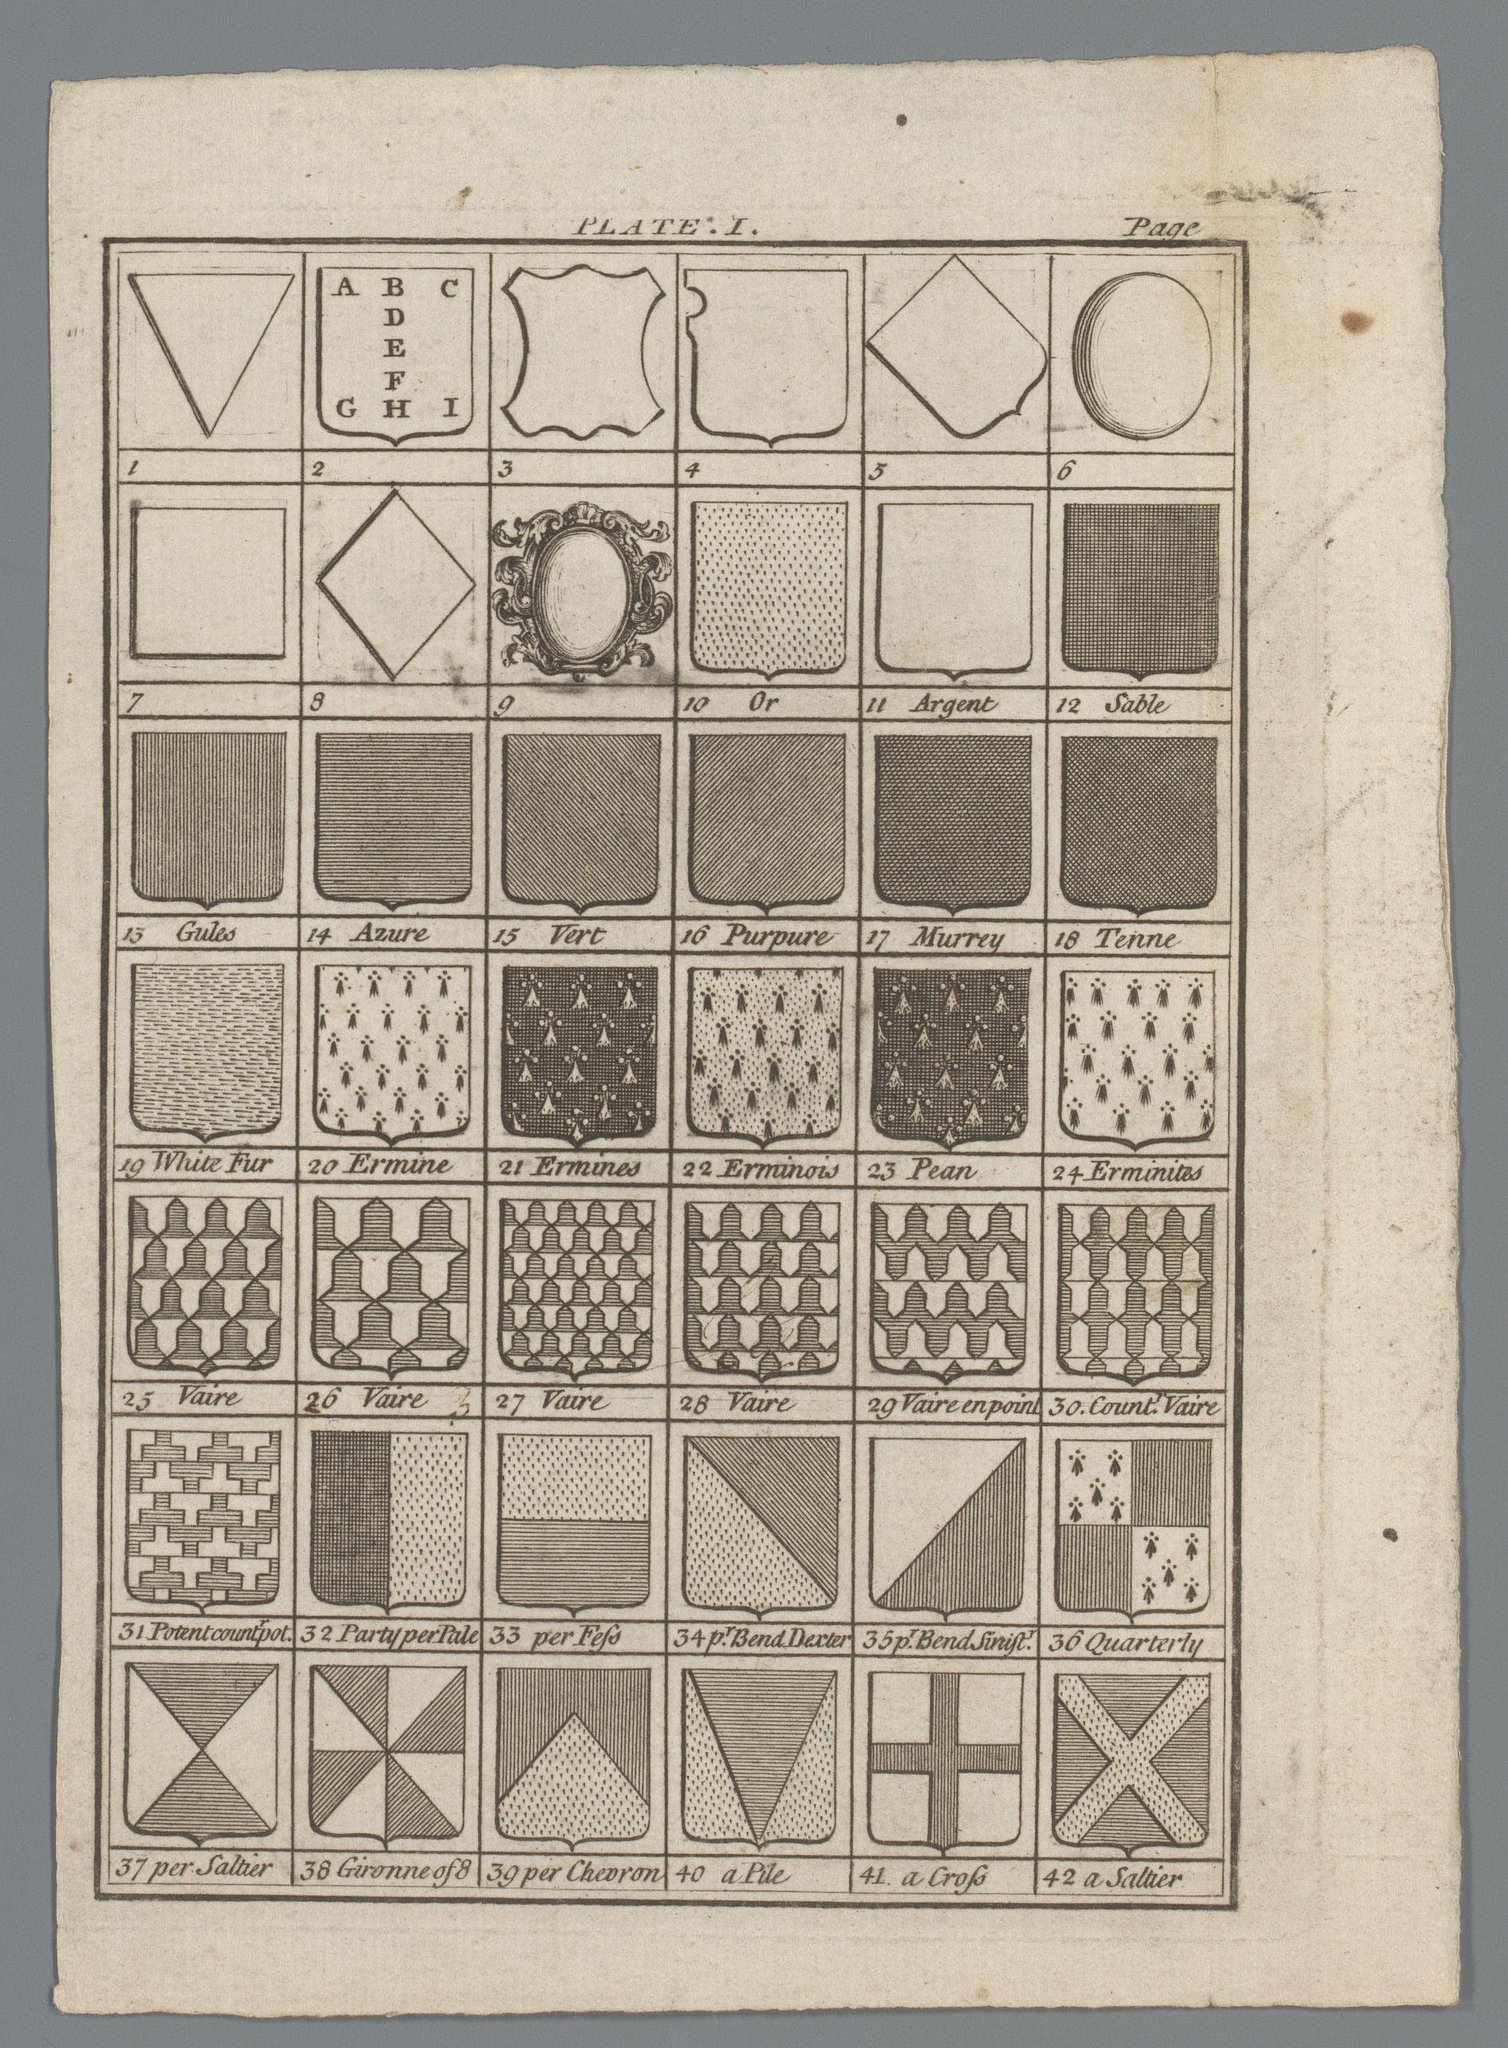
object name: print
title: Voorbeelden van verschillende wapenschilden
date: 1748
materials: paper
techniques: engraving, etching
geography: london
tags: armorial bearing, heraldry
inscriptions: inscription: ‘M Samuel Dufresnay in Great St/ Hellens in Bishopsgatestreet’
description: Prent uit: The Gentleman's Magazine 18 (1748), februari 1748.